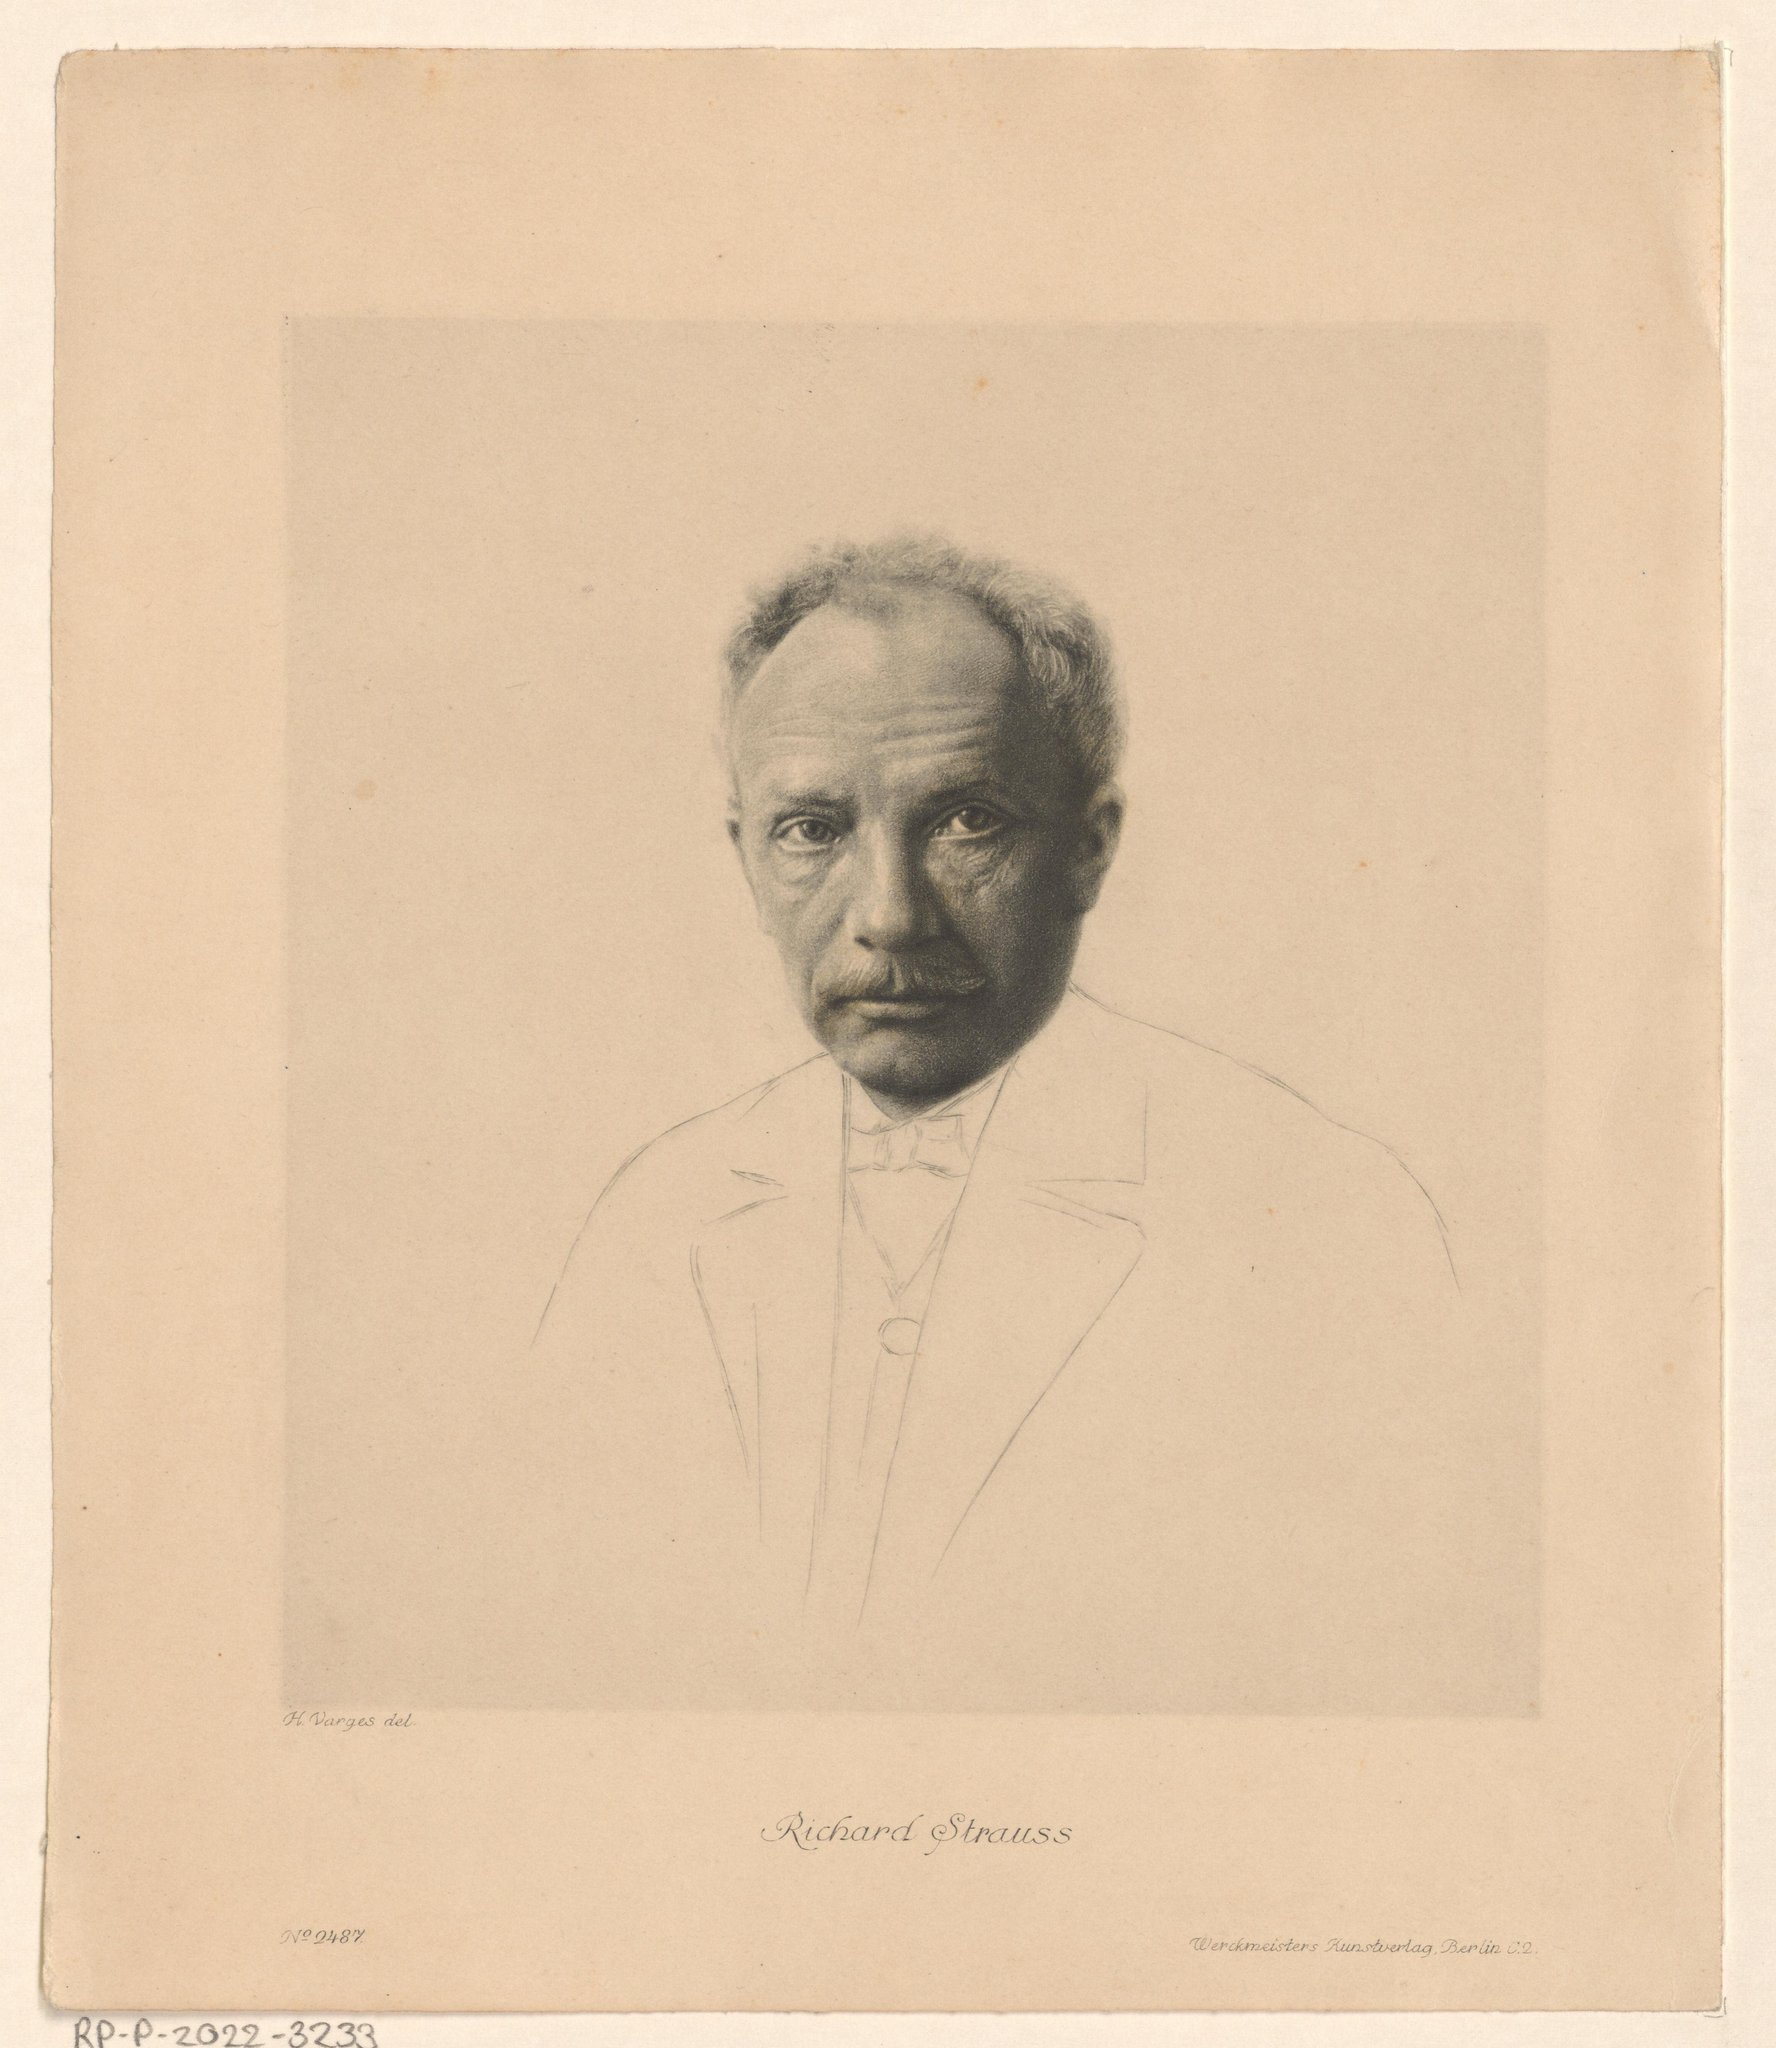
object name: print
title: Portret van Richard Strauss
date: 1937-1941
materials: paper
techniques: tone lithography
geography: berlin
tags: historical persons, portrait of composer